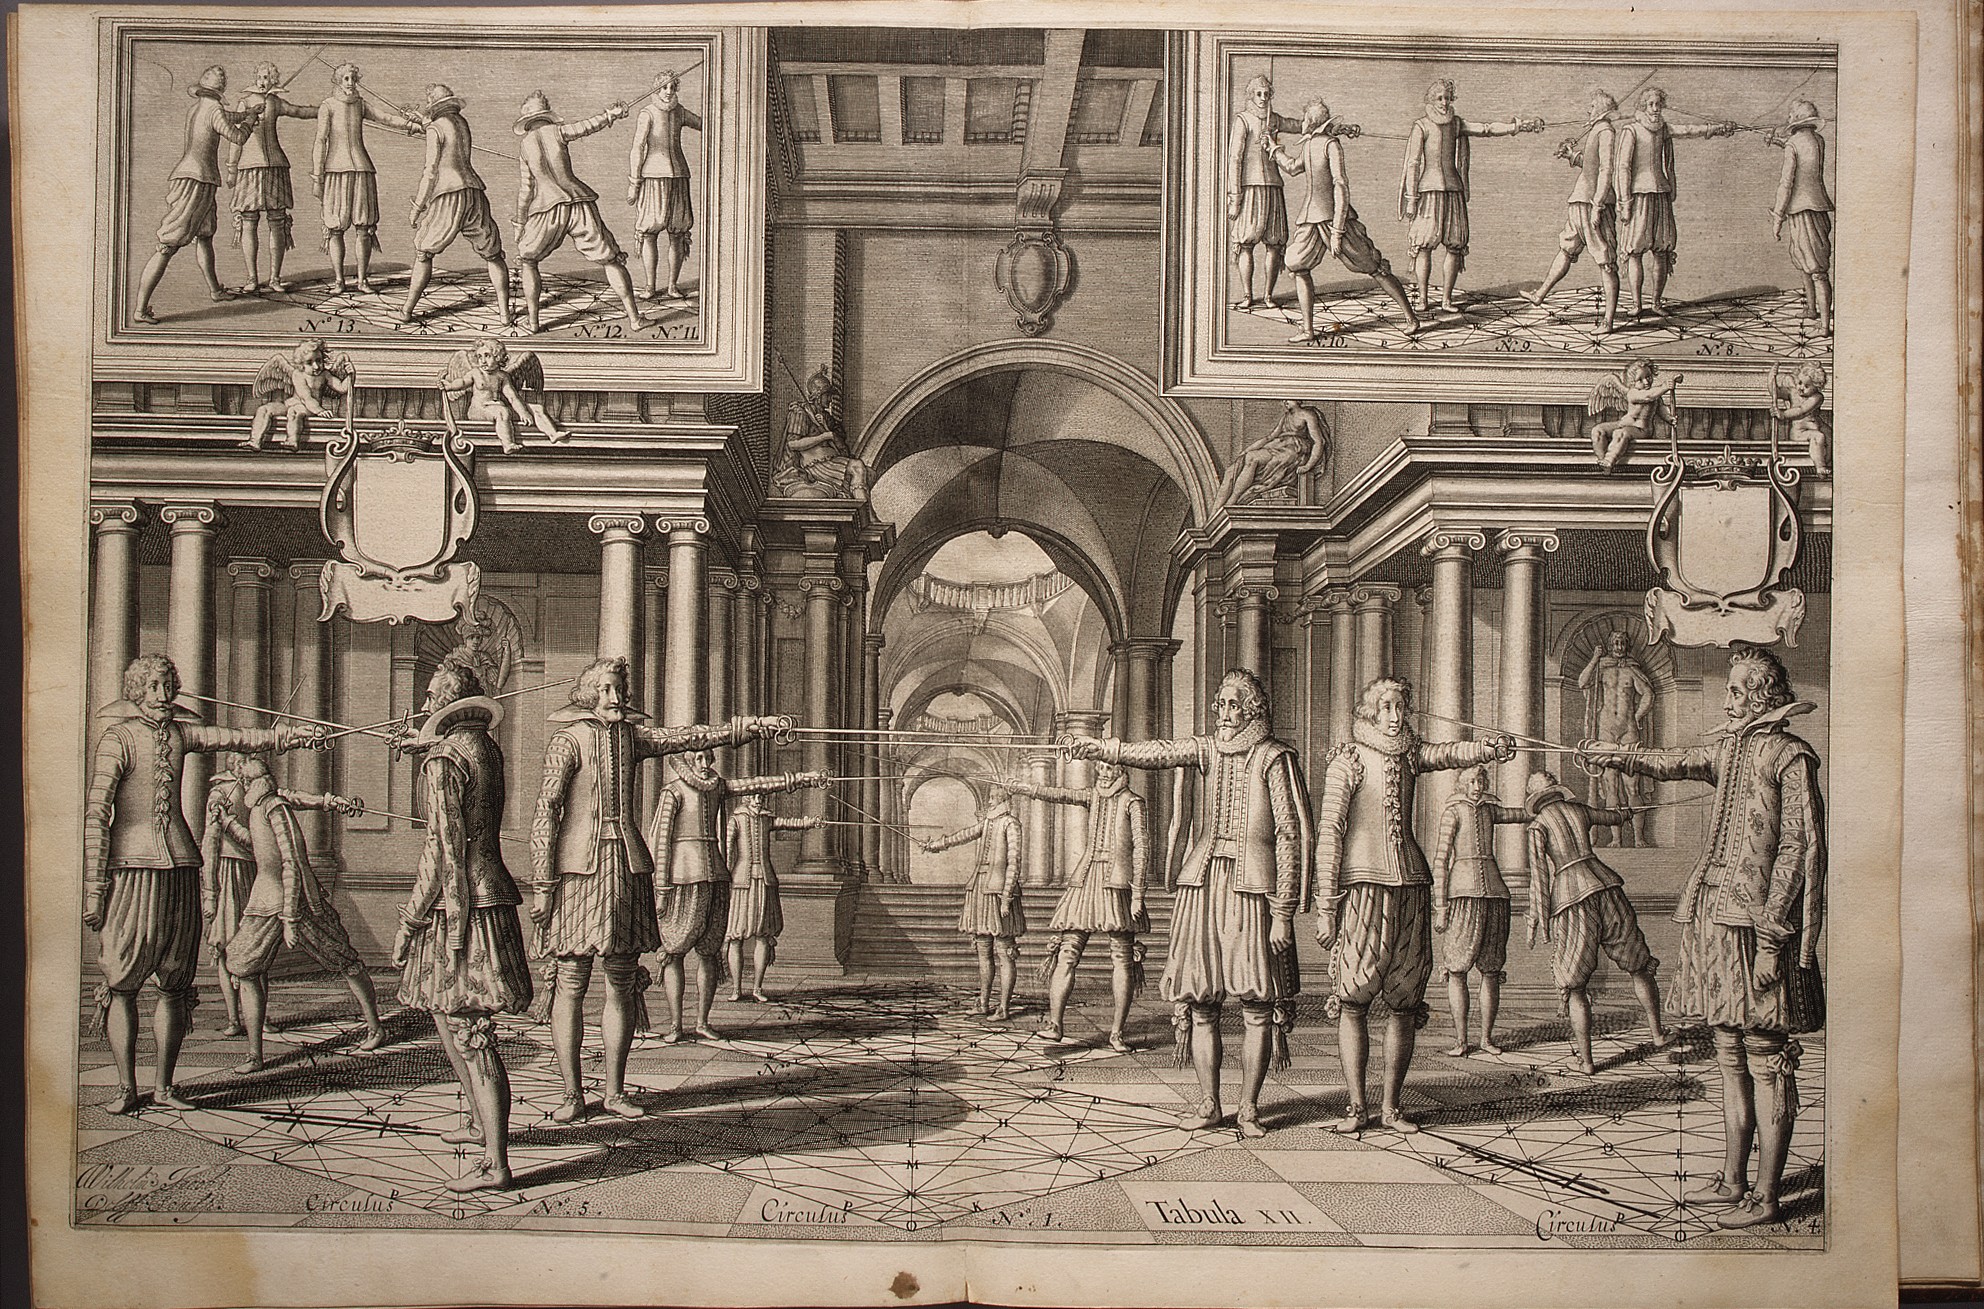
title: Academie de l'espee; ou se domonstrent par reigles mathématiques sur le fondement d'un cercle mystérieux, la théorie et pratique des vrais . . .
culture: flemish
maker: girard thibault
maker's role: author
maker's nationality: flemish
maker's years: 1629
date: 1628